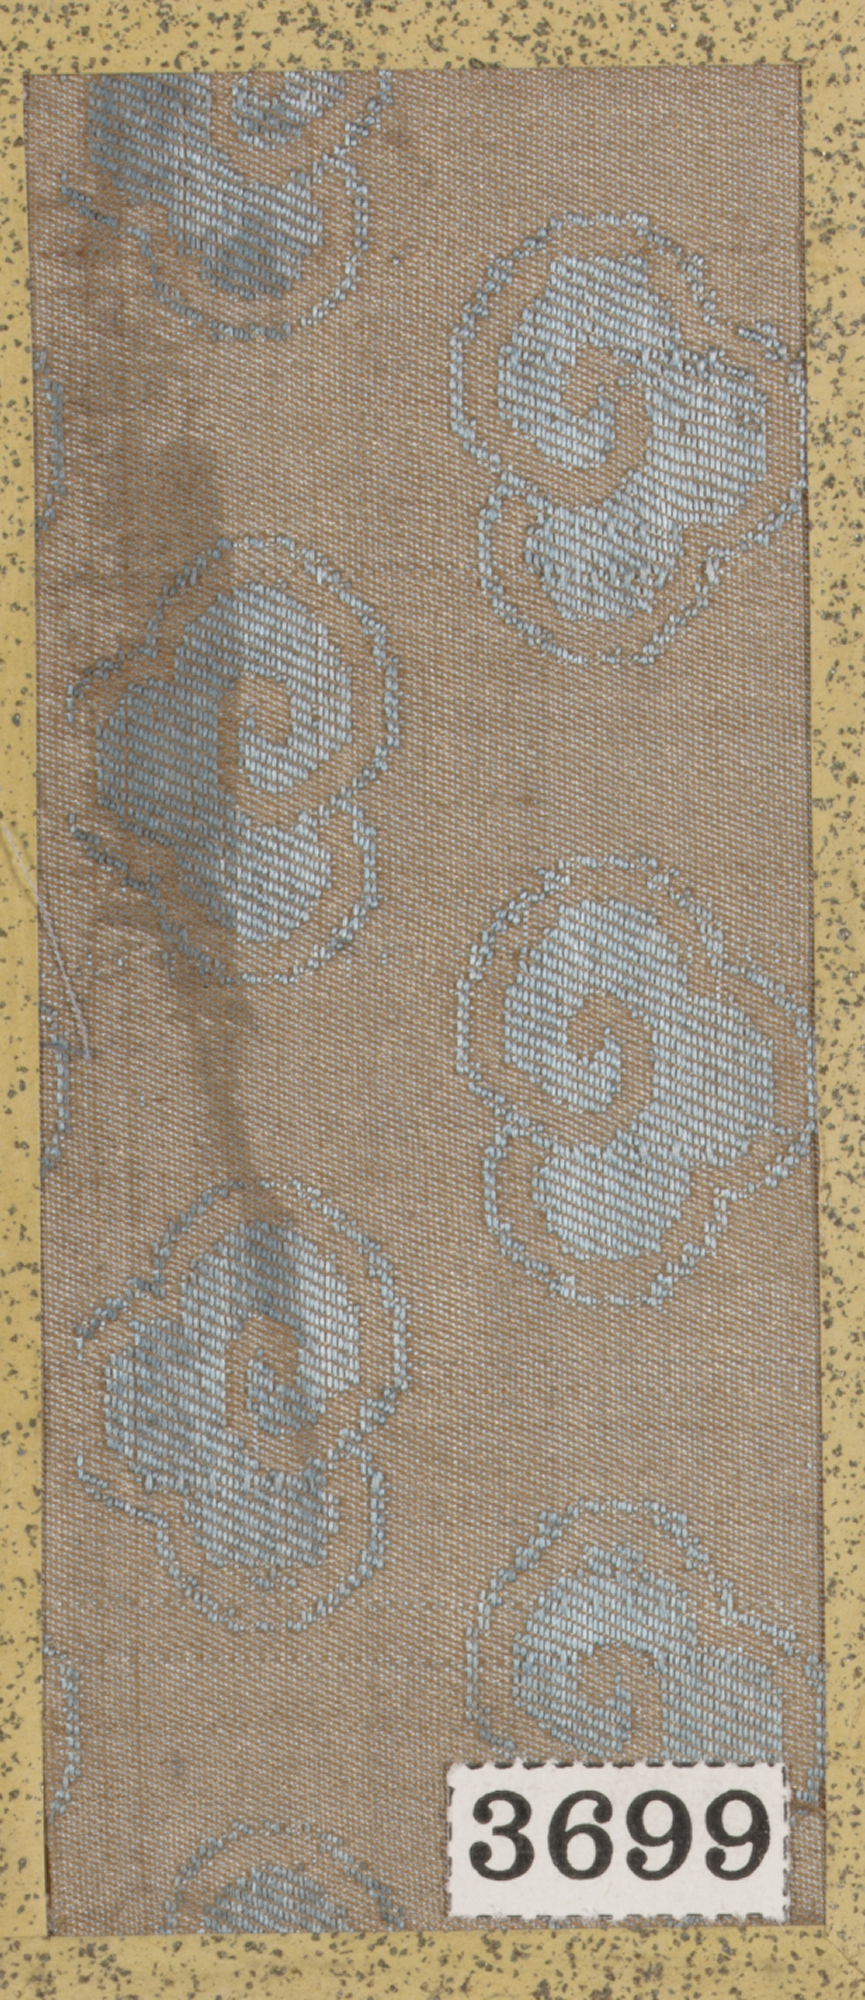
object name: sample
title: Textile Sample from Sample Book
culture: japanese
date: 1801-1900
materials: silk